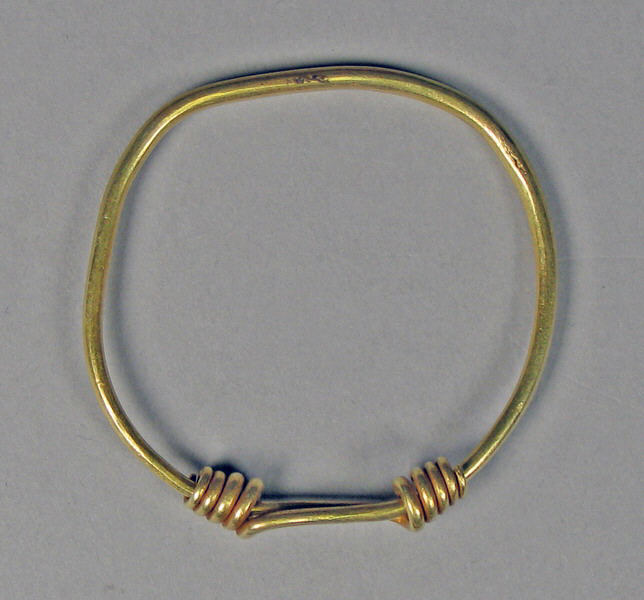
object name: bracelet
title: Bracelet, Hammered Wire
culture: indonesian, central java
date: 701-1200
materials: gold